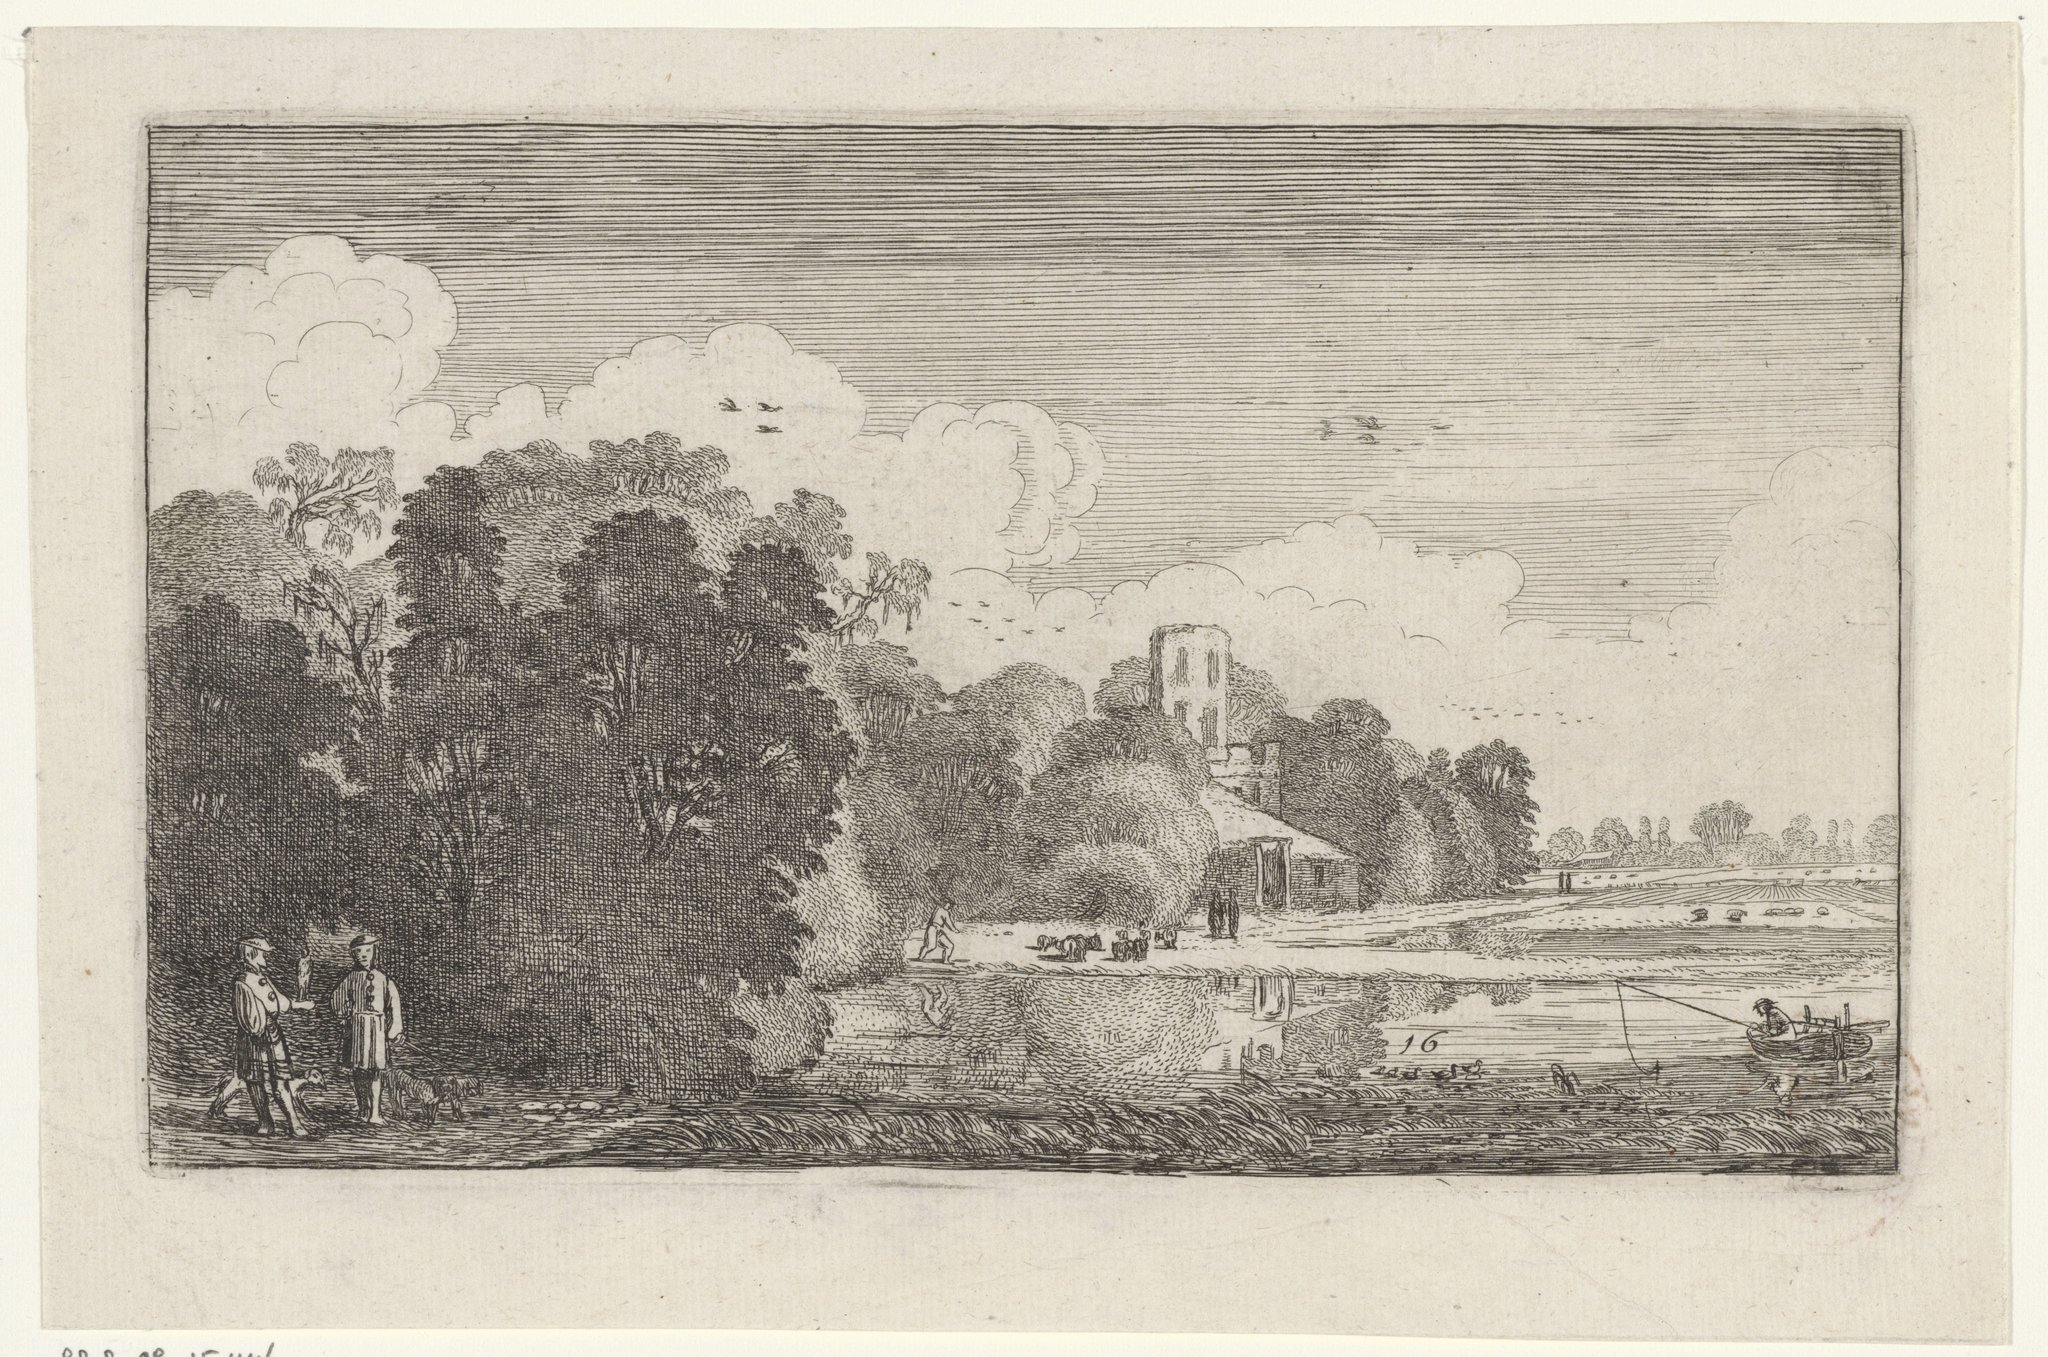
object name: print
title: Valkenier en knecht in een bomenrijk landschap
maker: jan van de velde (ii)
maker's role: draughtsman, painter, print maker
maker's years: 1593-1641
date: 1616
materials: paper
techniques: etching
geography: northern netherlands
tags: sports, games ~ animals (+ hunting with falcon, hawk; falconry), farm or solitary house in landscape, angling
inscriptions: collector's mark: Lugt 240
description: Valkenier en knecht in een bomenrijk landschap met een vijver waarop een hengelaar in een boot. Op de achtergrond een ruïne tussen bomen. Zestiende prent uit een serie van zestien.